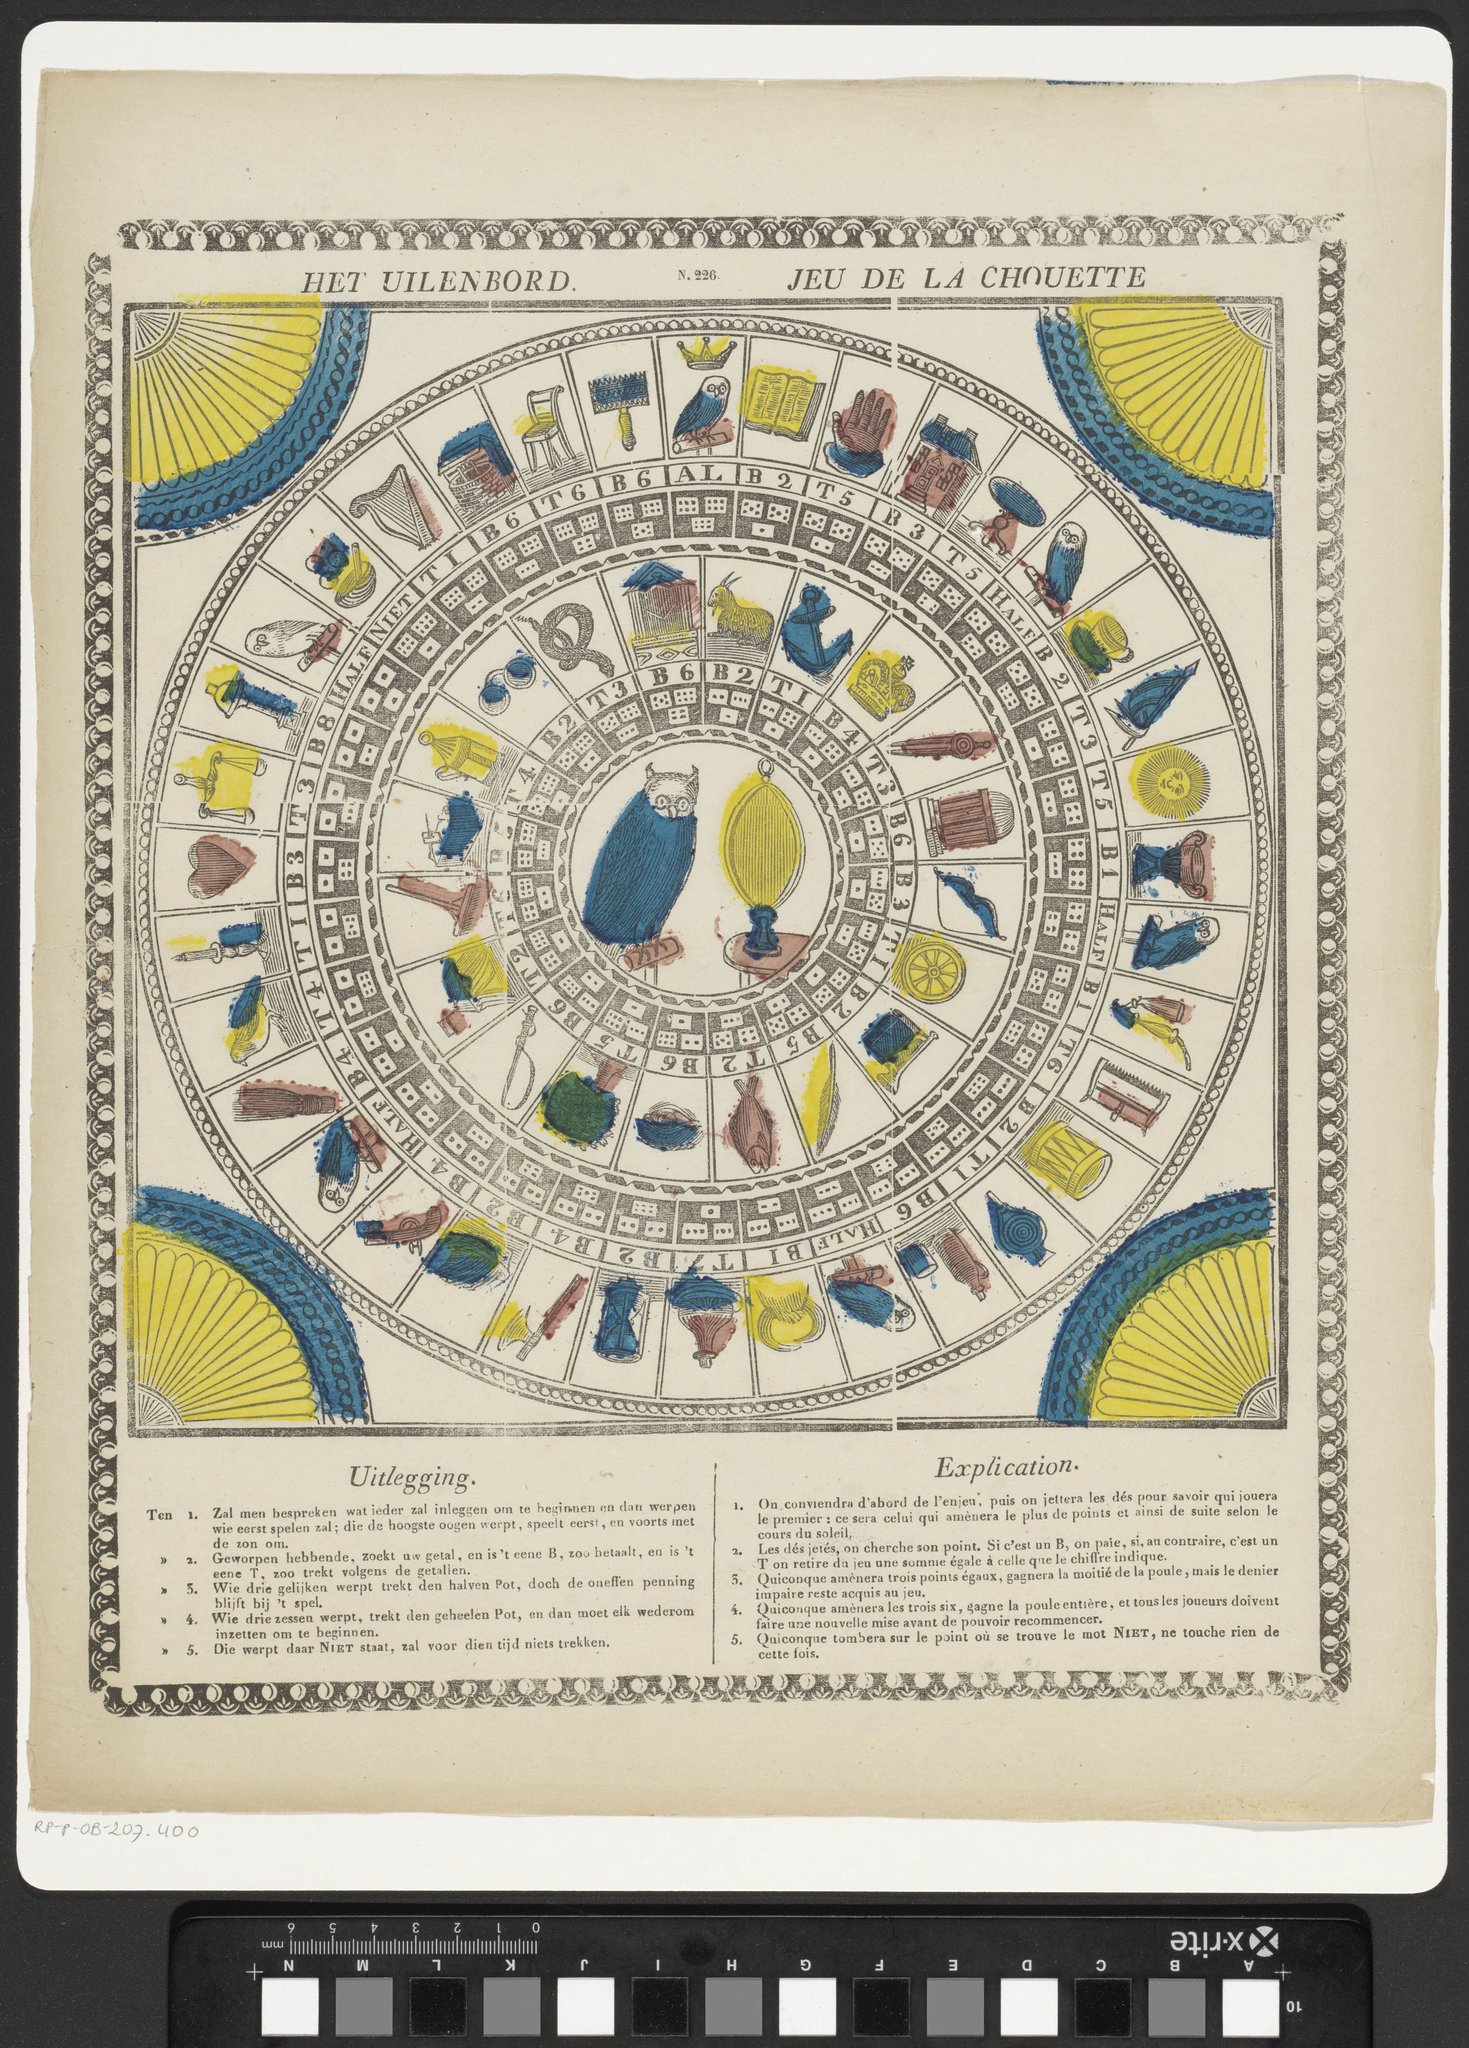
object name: print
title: Het uilenbord / Jeu de la chouette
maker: Anonymous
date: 1800-1899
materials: paper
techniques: colour, letterpress printing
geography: europe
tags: board-games of chance, owls, board-games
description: Het Uilenspel. Een cirkelvormig bordspel met vakjes met daarin voorstellingen van voorwerpen, dieren en dobbelstenen. In het midden een voorstelling van een uil met een spiegel. Onder de voorstelling de spelregels in het Nederlands en in het Frans. Genummerd midden boven: N. 266.